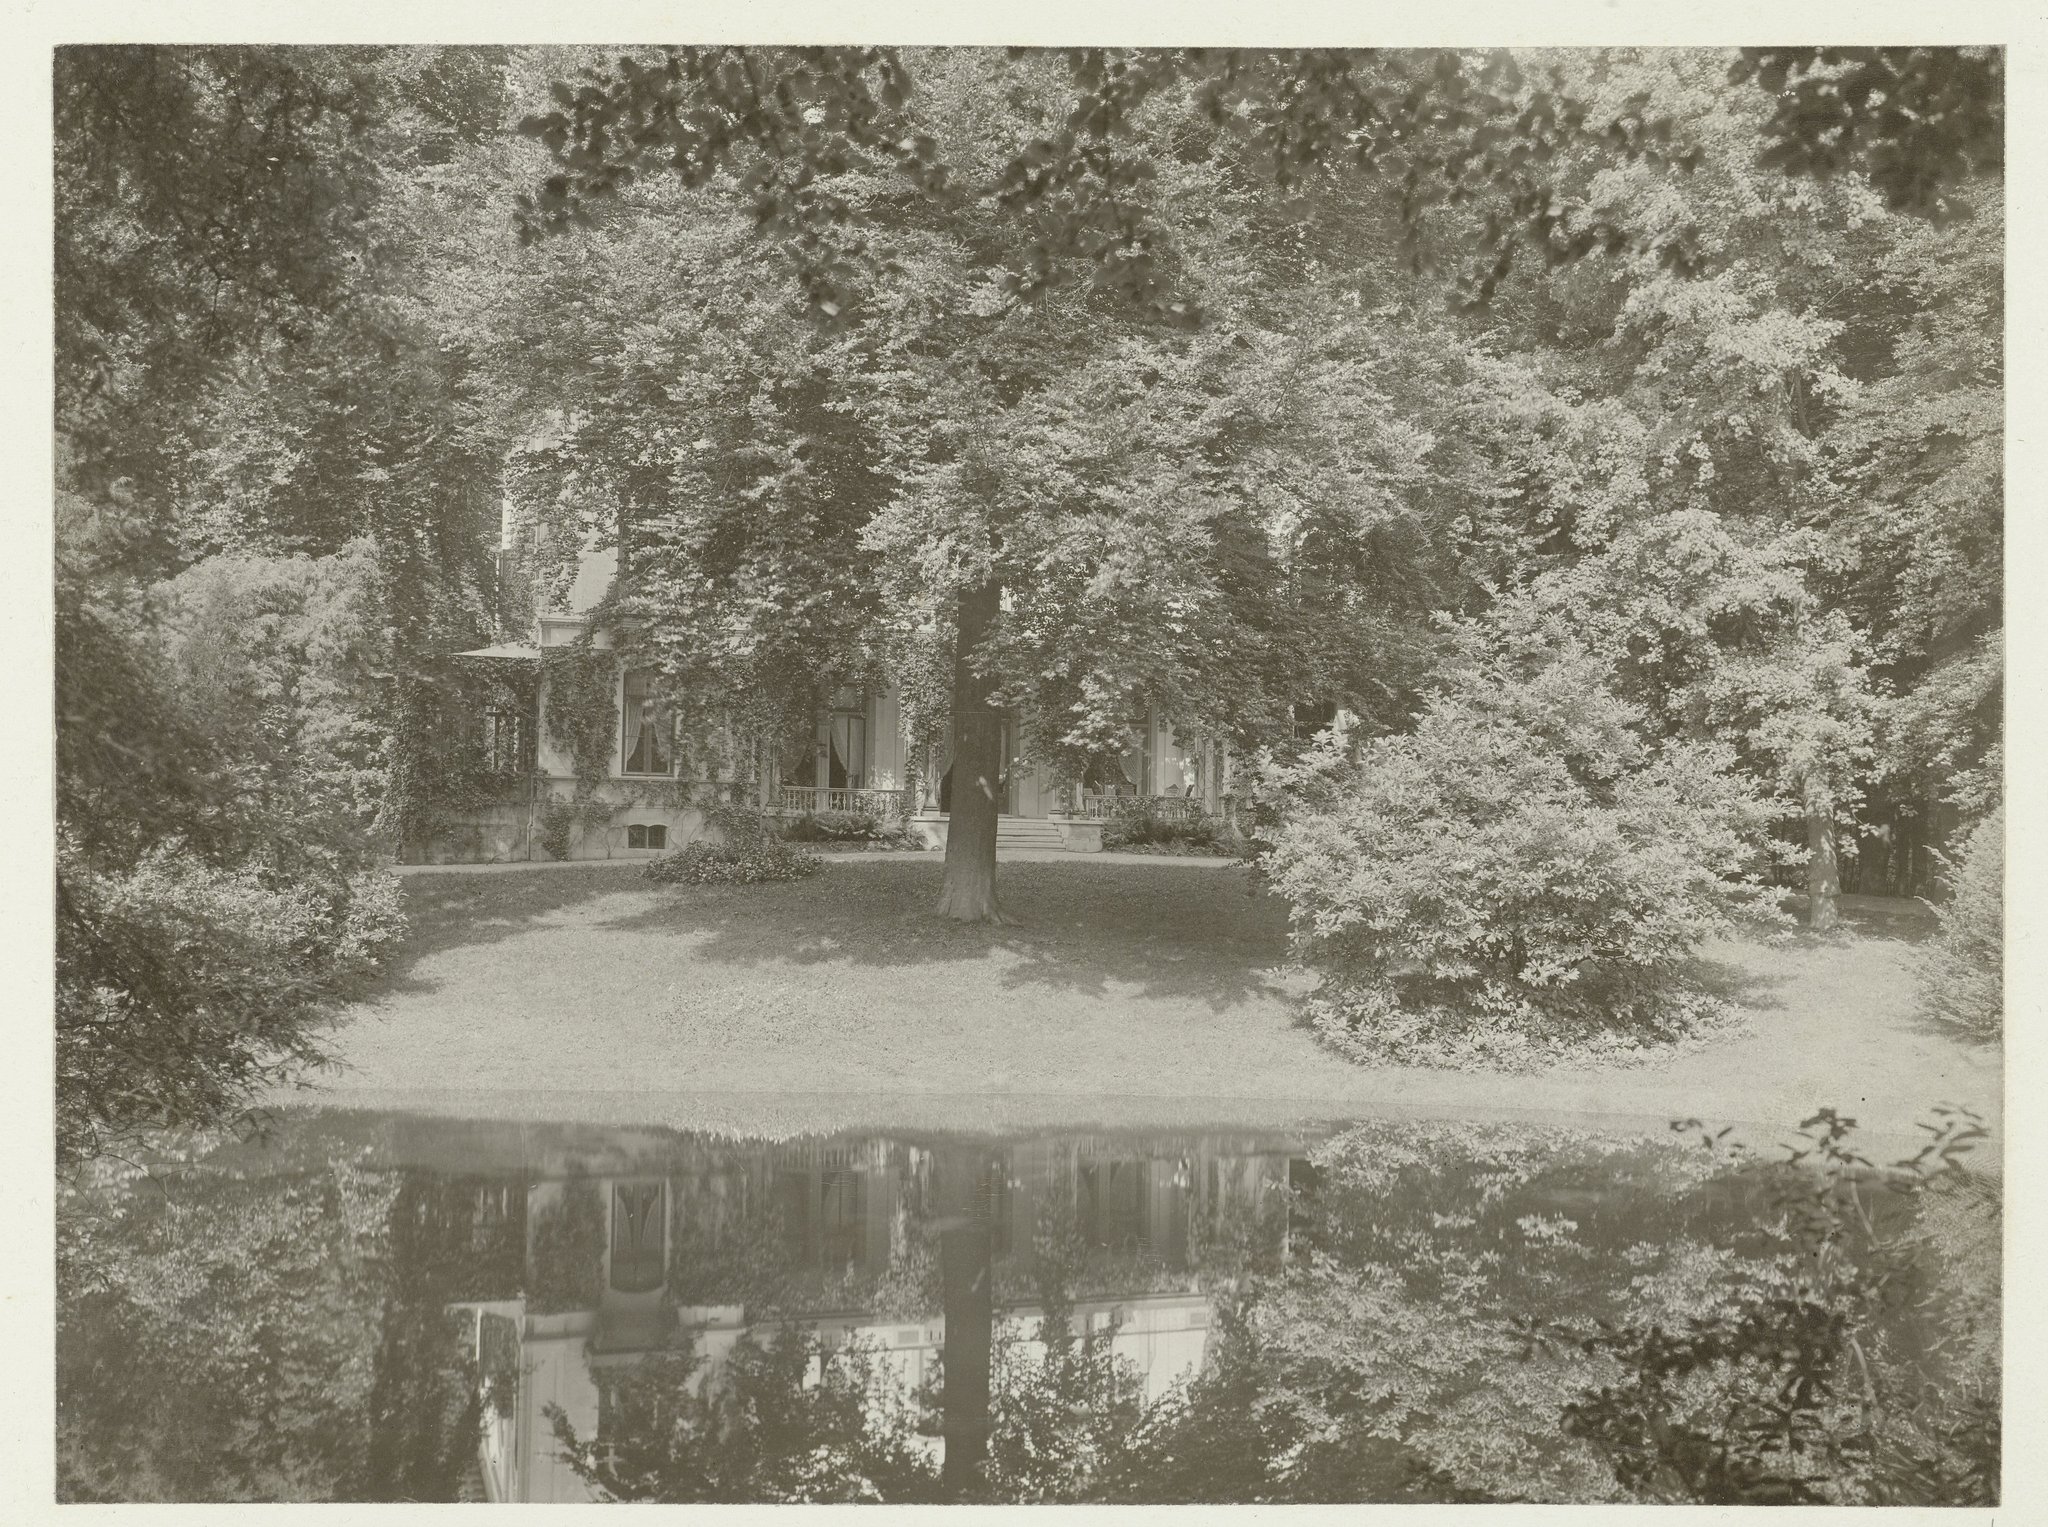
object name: photograph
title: Gezicht op landhuis De Wildbaan, Driebergen, het woonhuis van de fotograaf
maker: henry pauw van wieldrecht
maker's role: fotograaf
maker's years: 1863-1912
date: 1903-1907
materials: paper, photographic support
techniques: gelatin silver print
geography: netherlands